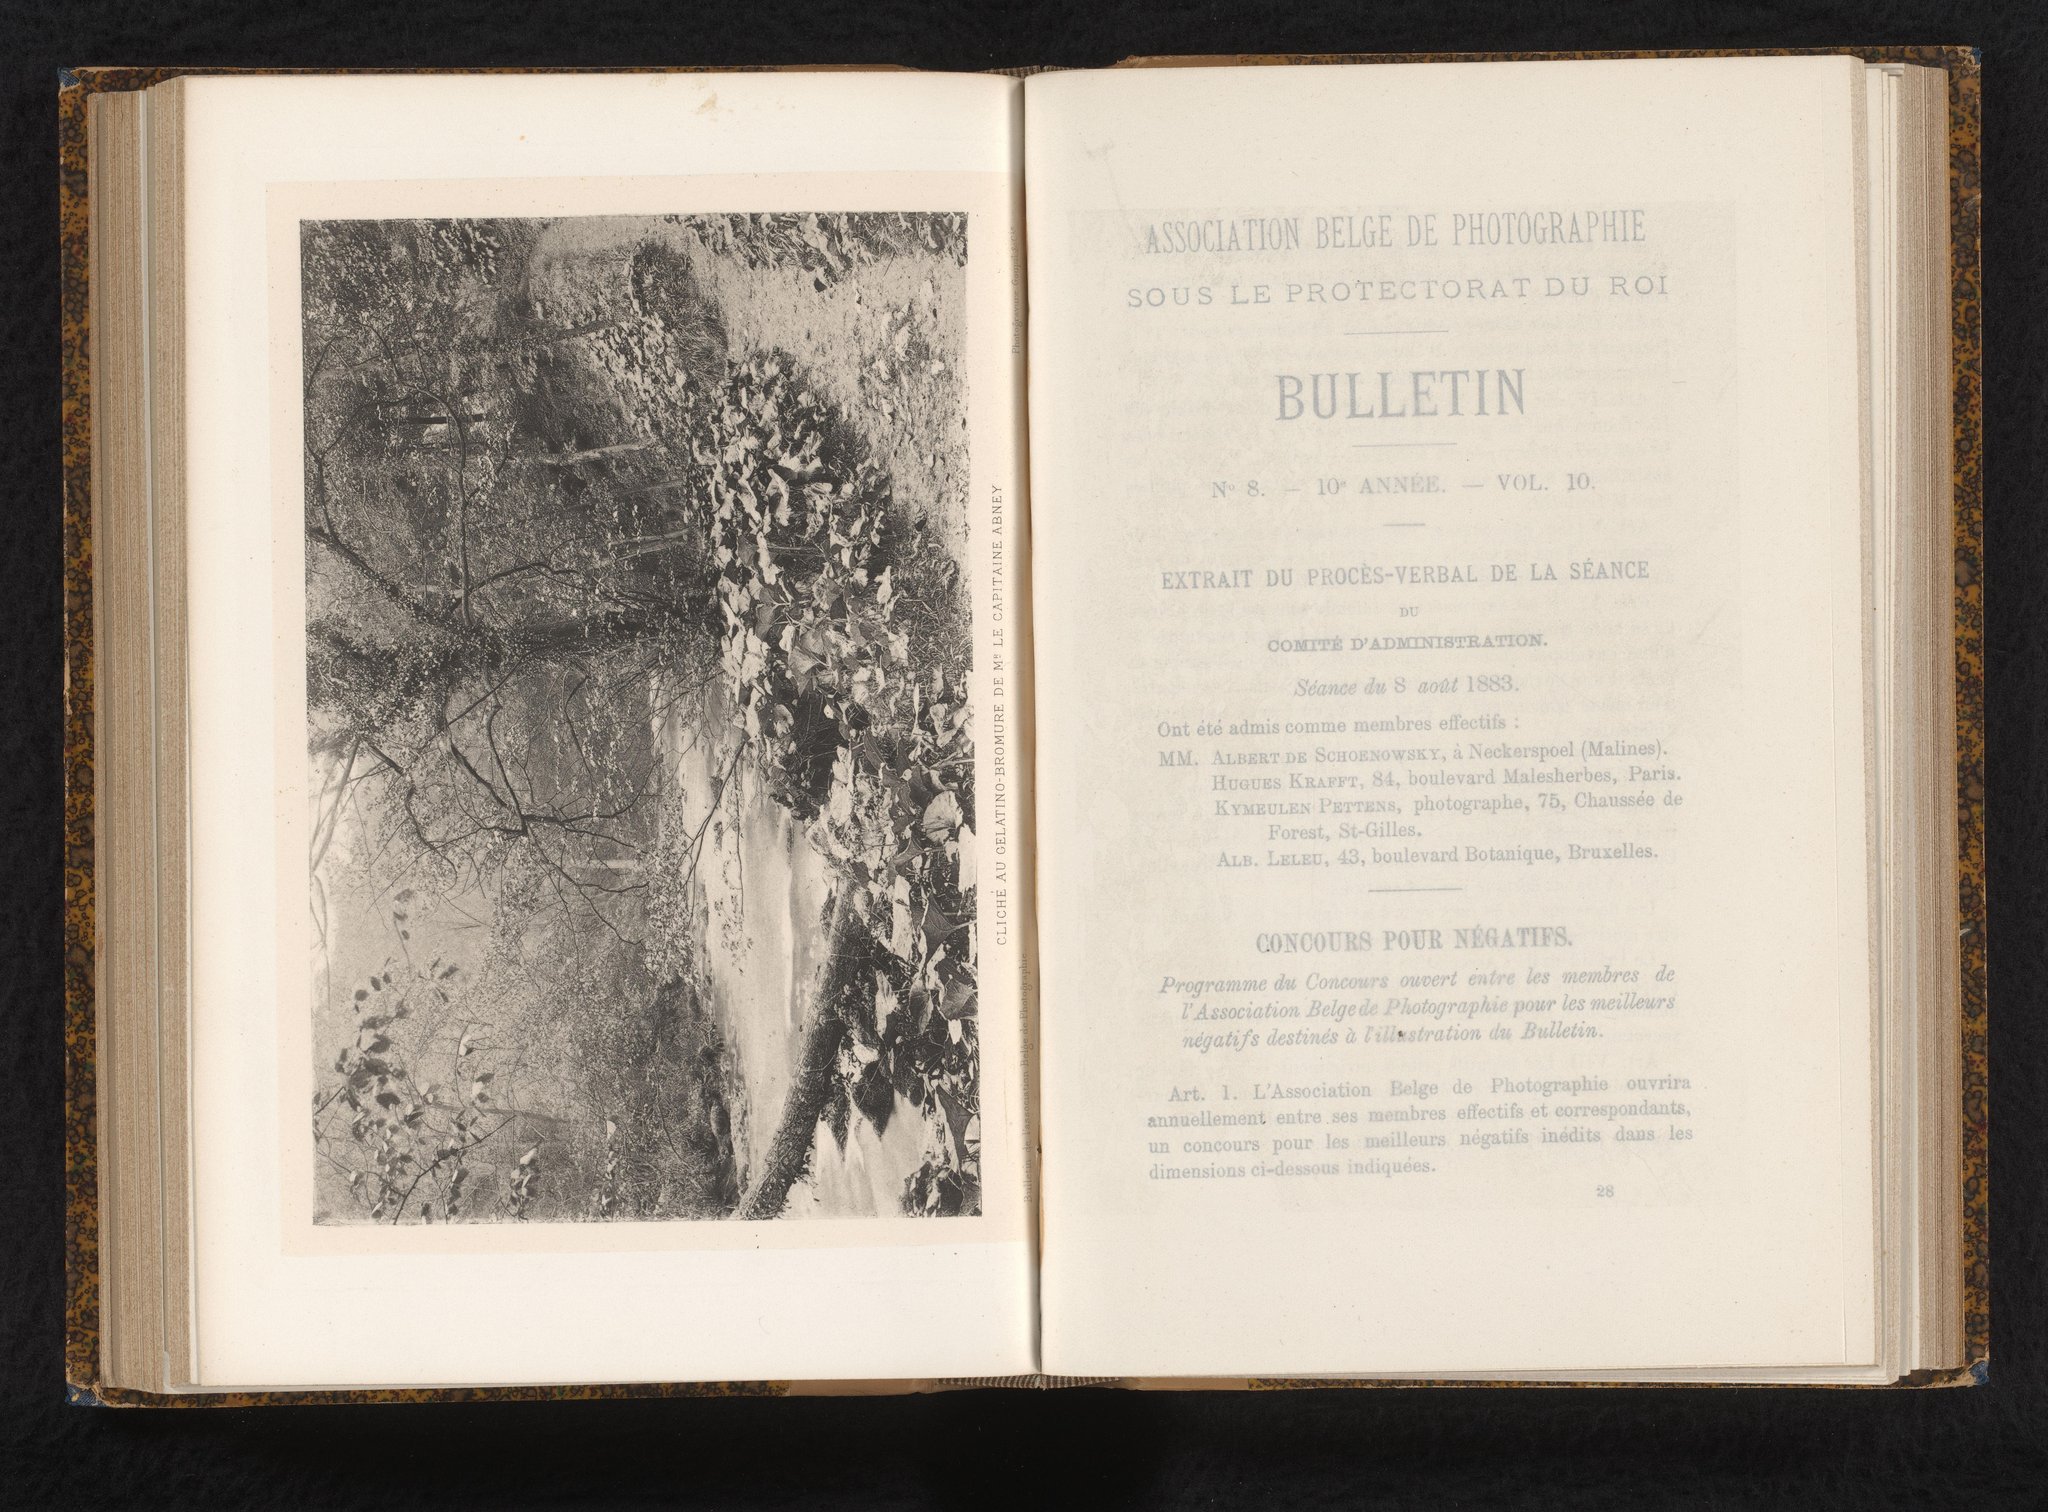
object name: page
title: Beek in een bos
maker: sir william de wiveleslie abney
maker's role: astronoom, chemicus, fotograaf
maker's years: 1843-1920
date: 1878-1883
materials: paper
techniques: photoaquatint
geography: paris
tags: forest, wood, brook, forest path or lane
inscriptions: inscription: ‘Cliché au gelatino-bromure de Mr le Capitaine Abney’